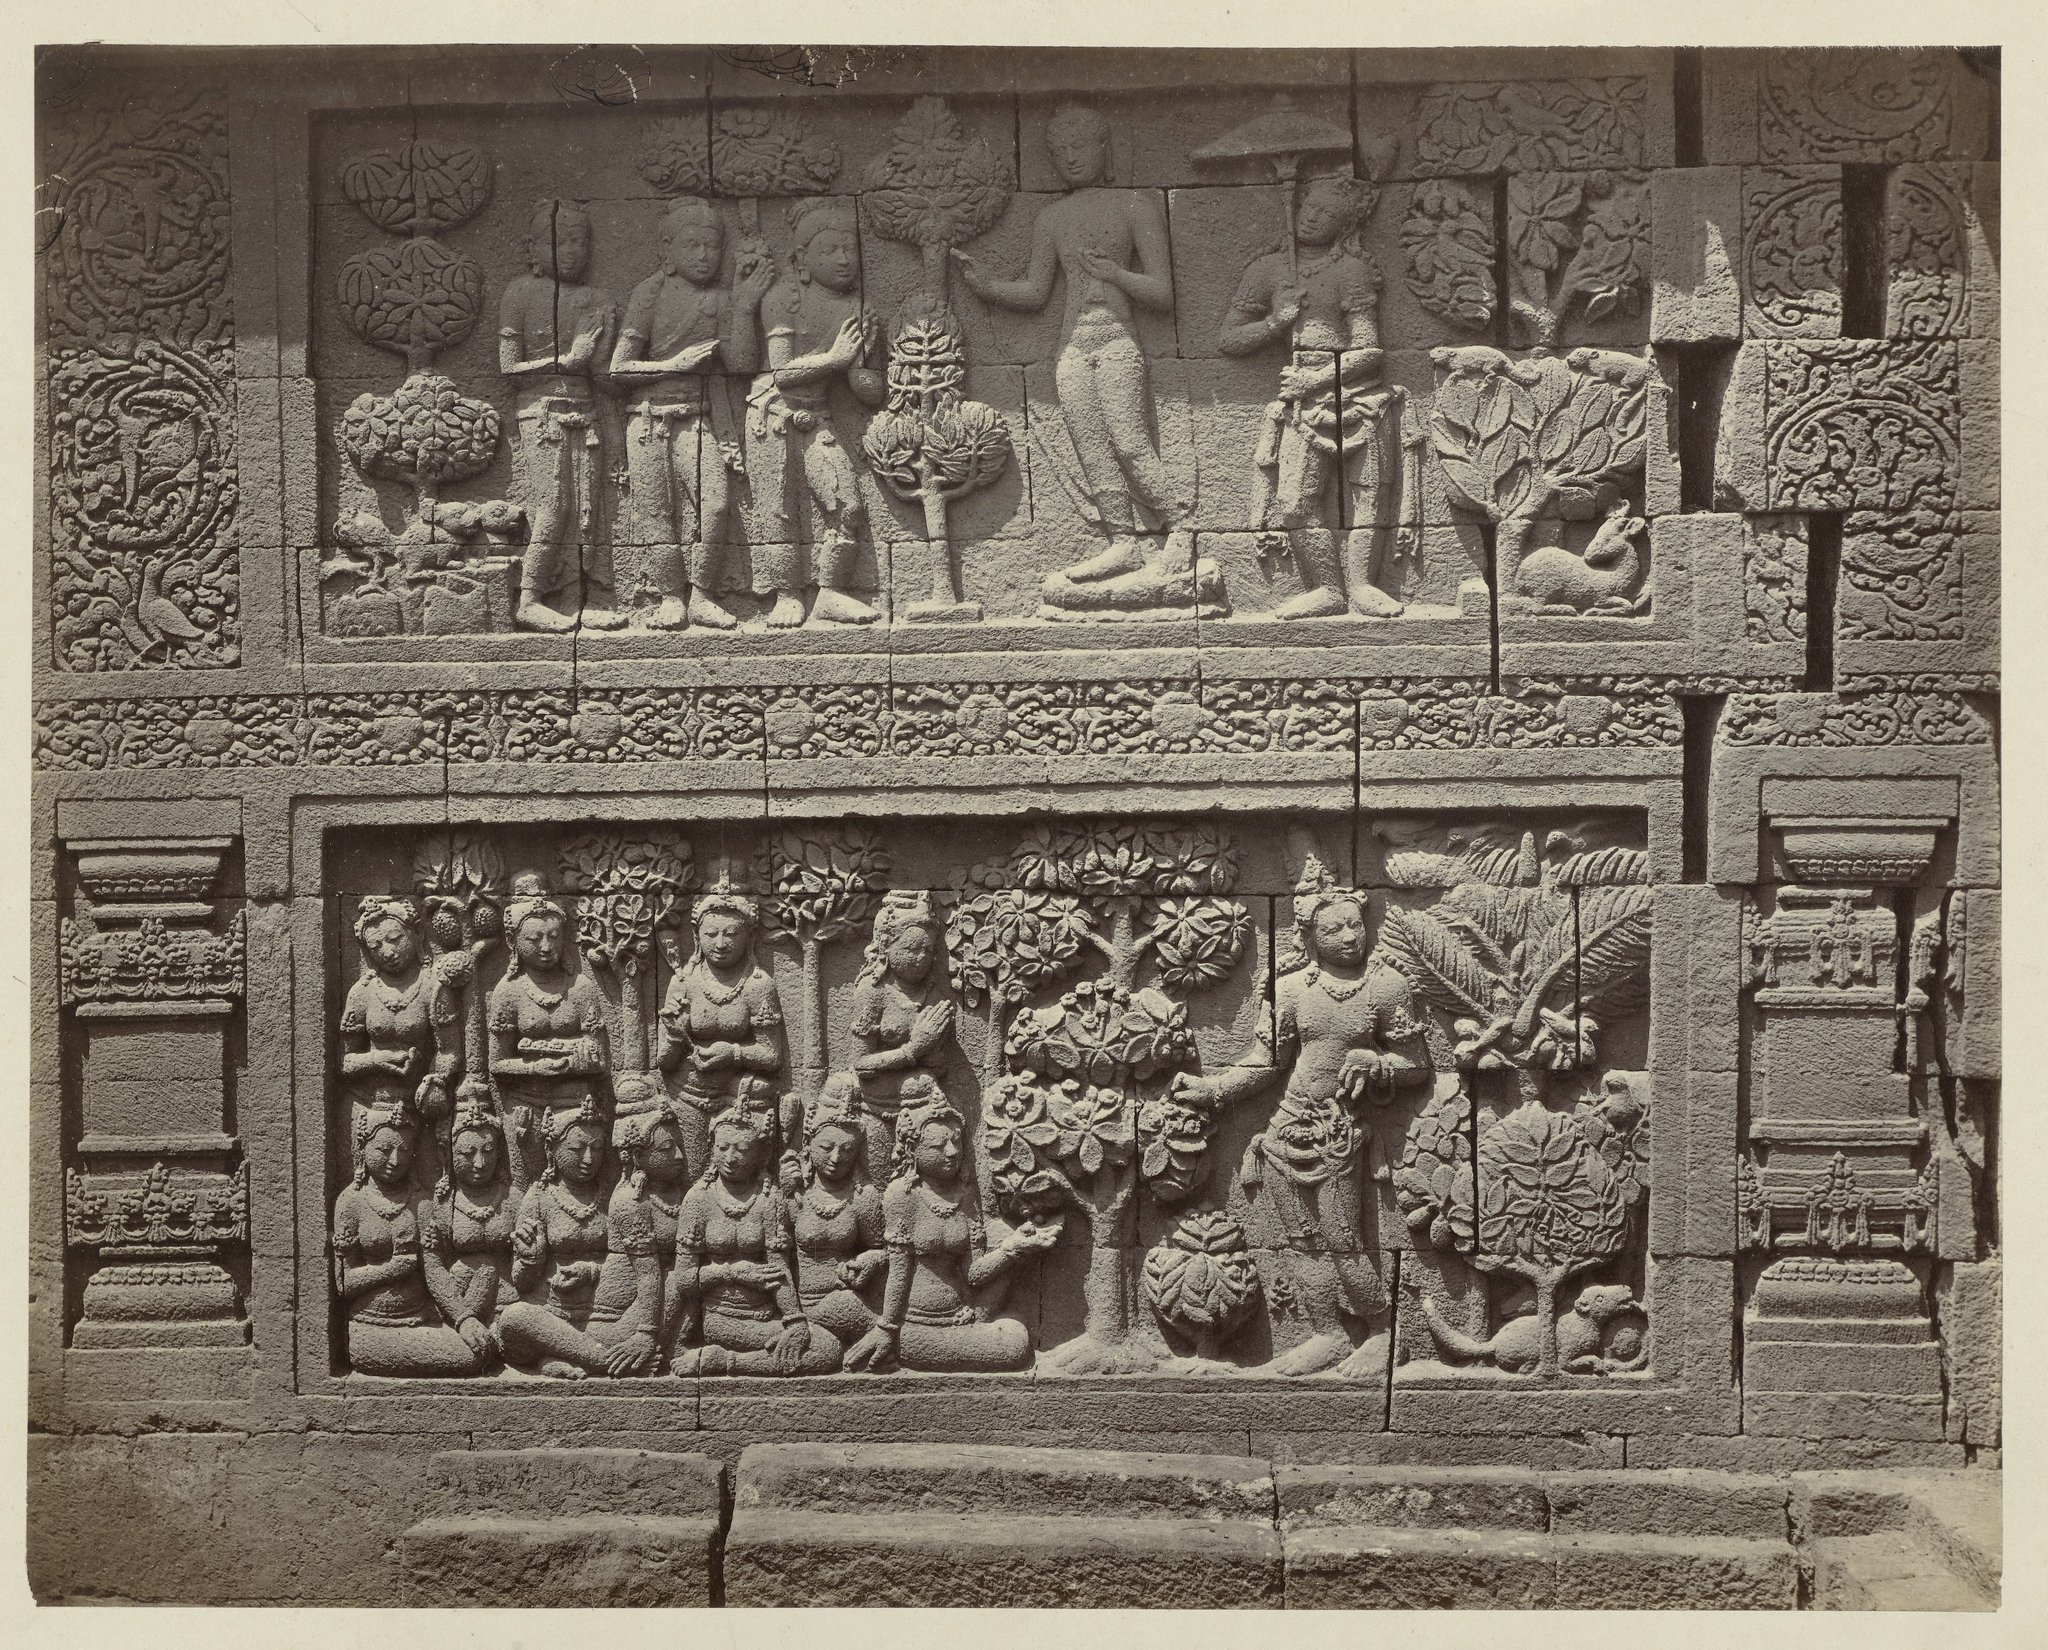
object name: photograph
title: Idem 2e gaanderij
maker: isidore kinsbergen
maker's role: fotograaf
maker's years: 1821-1905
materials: cardboard, paper, photographic support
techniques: albumen print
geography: java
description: ook afgebeeld reliëf 1b 110, het Avadana en Maitrakanyaka.